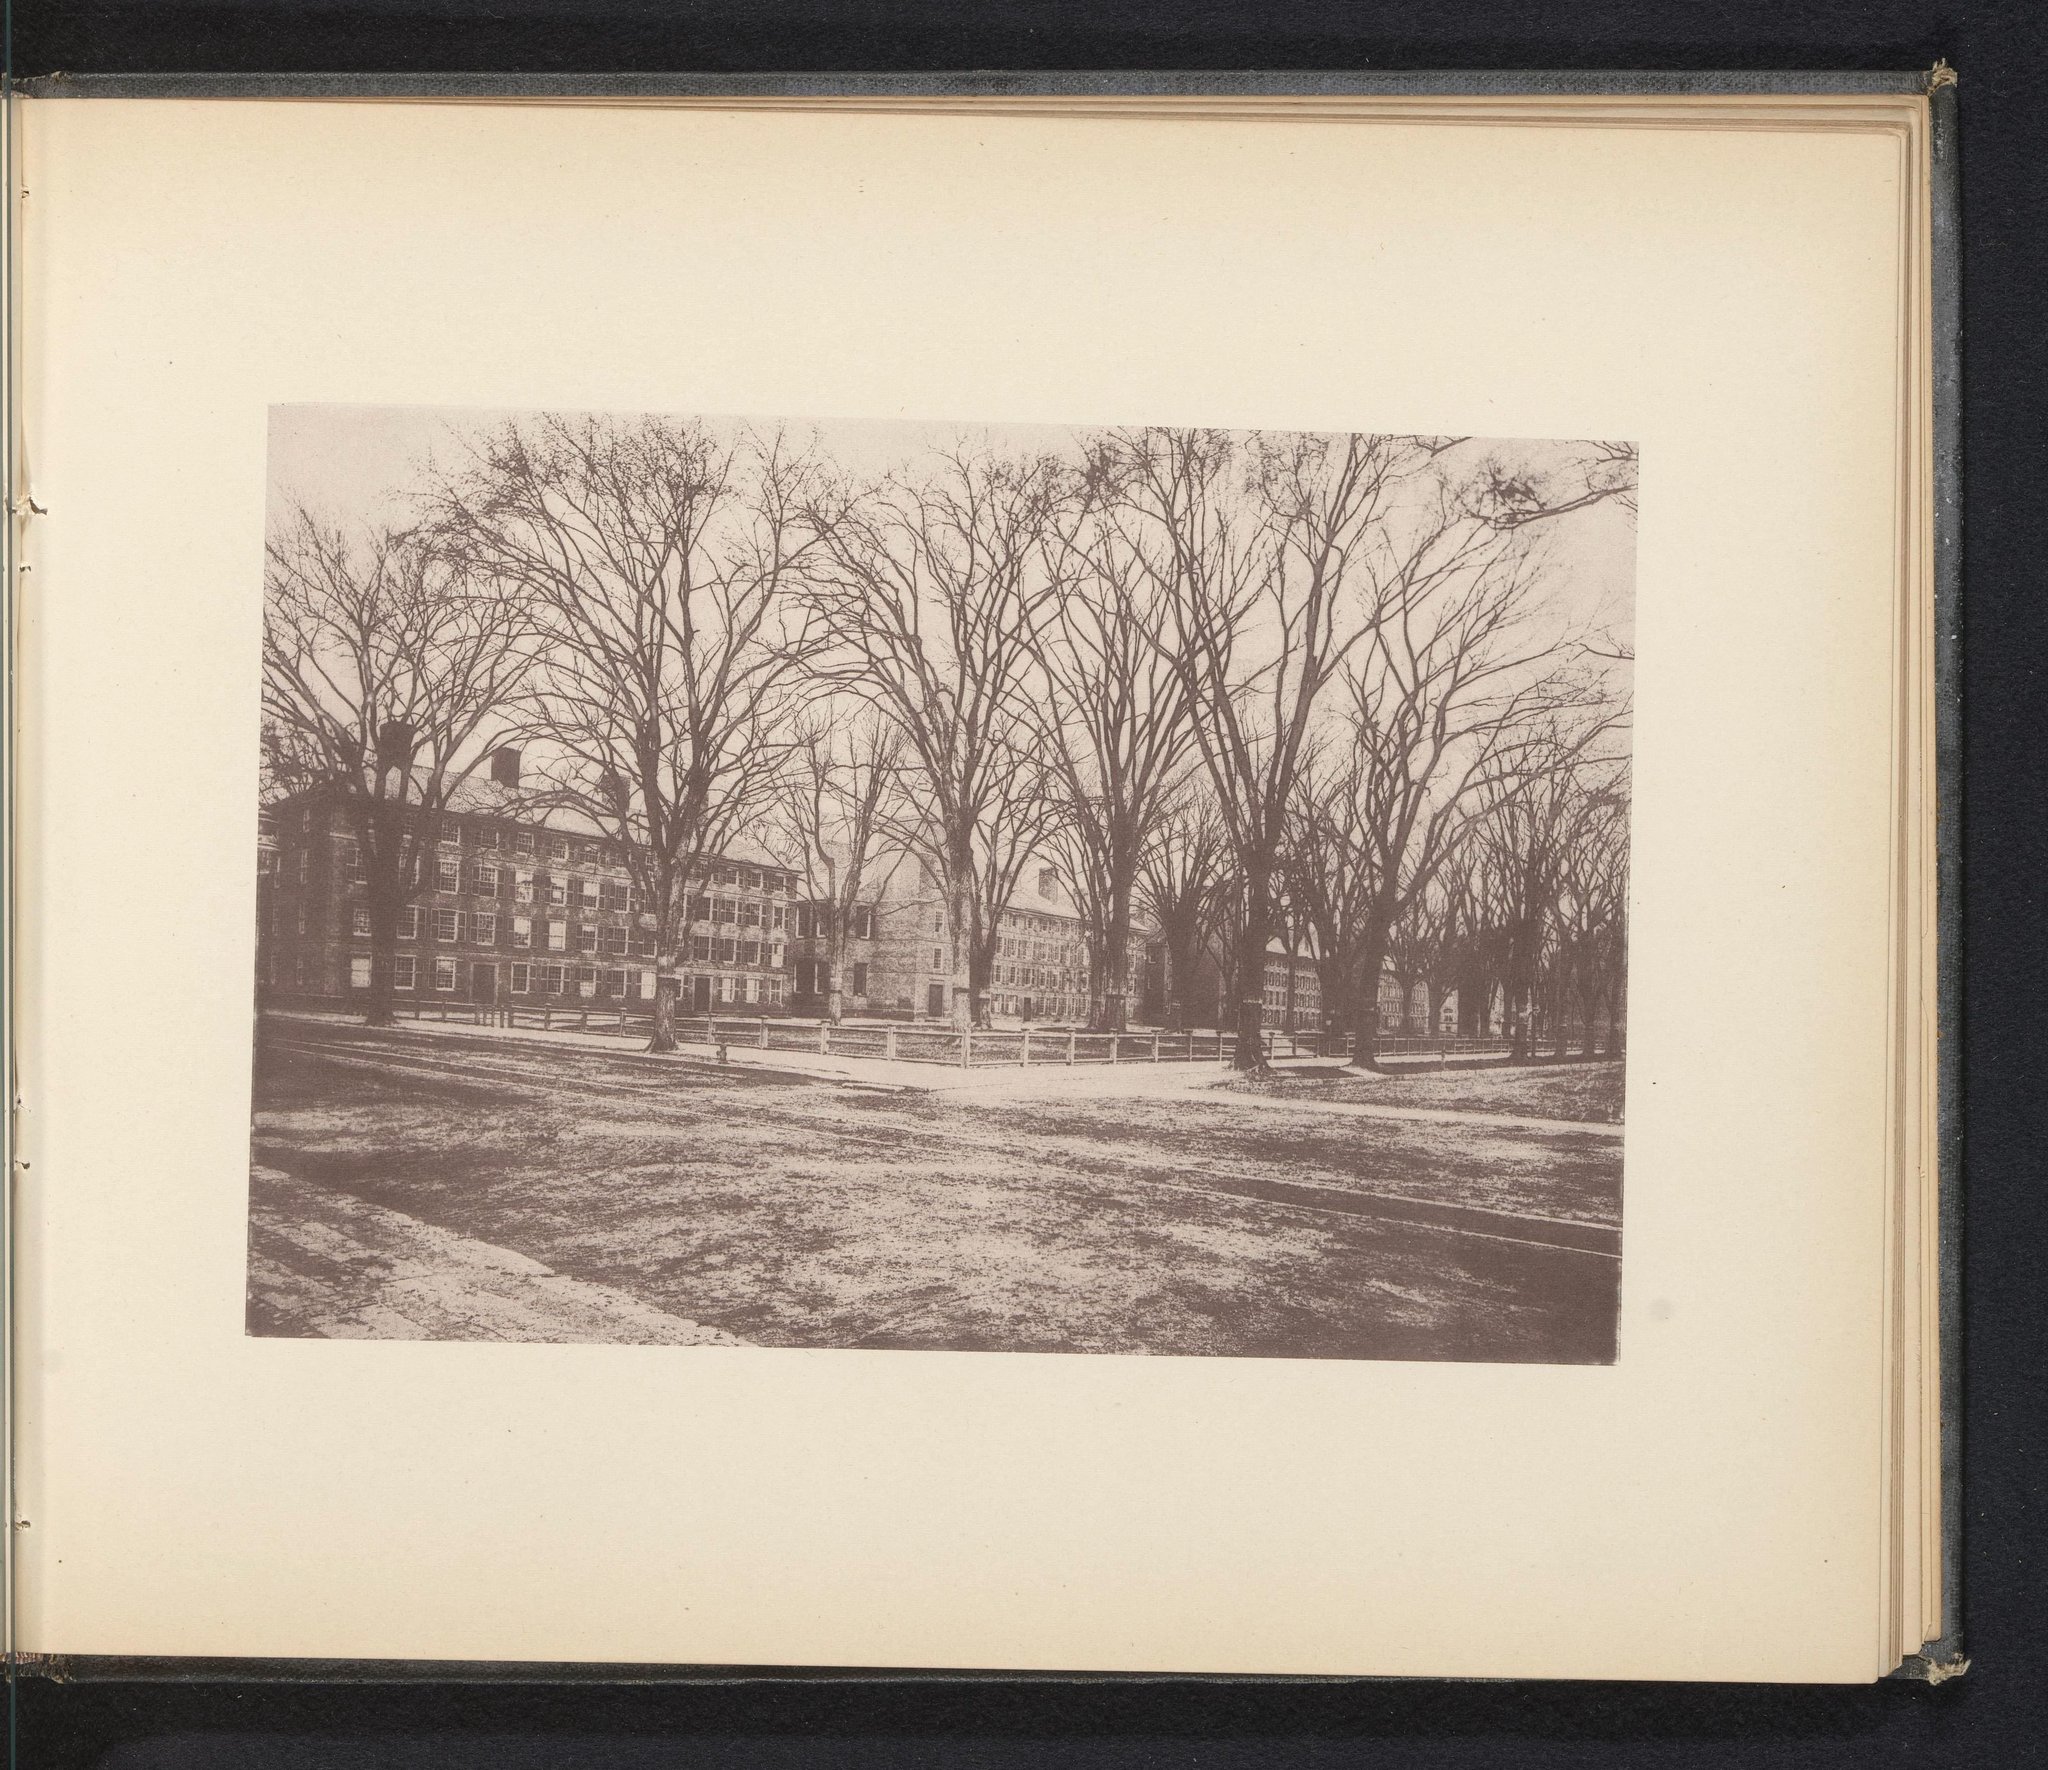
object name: photomechanical print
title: Gezicht op de campus van Yale University te New Haven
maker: Anonymous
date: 1890-1895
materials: paper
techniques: photograph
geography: new haven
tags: university building, college, façade (of house or building)